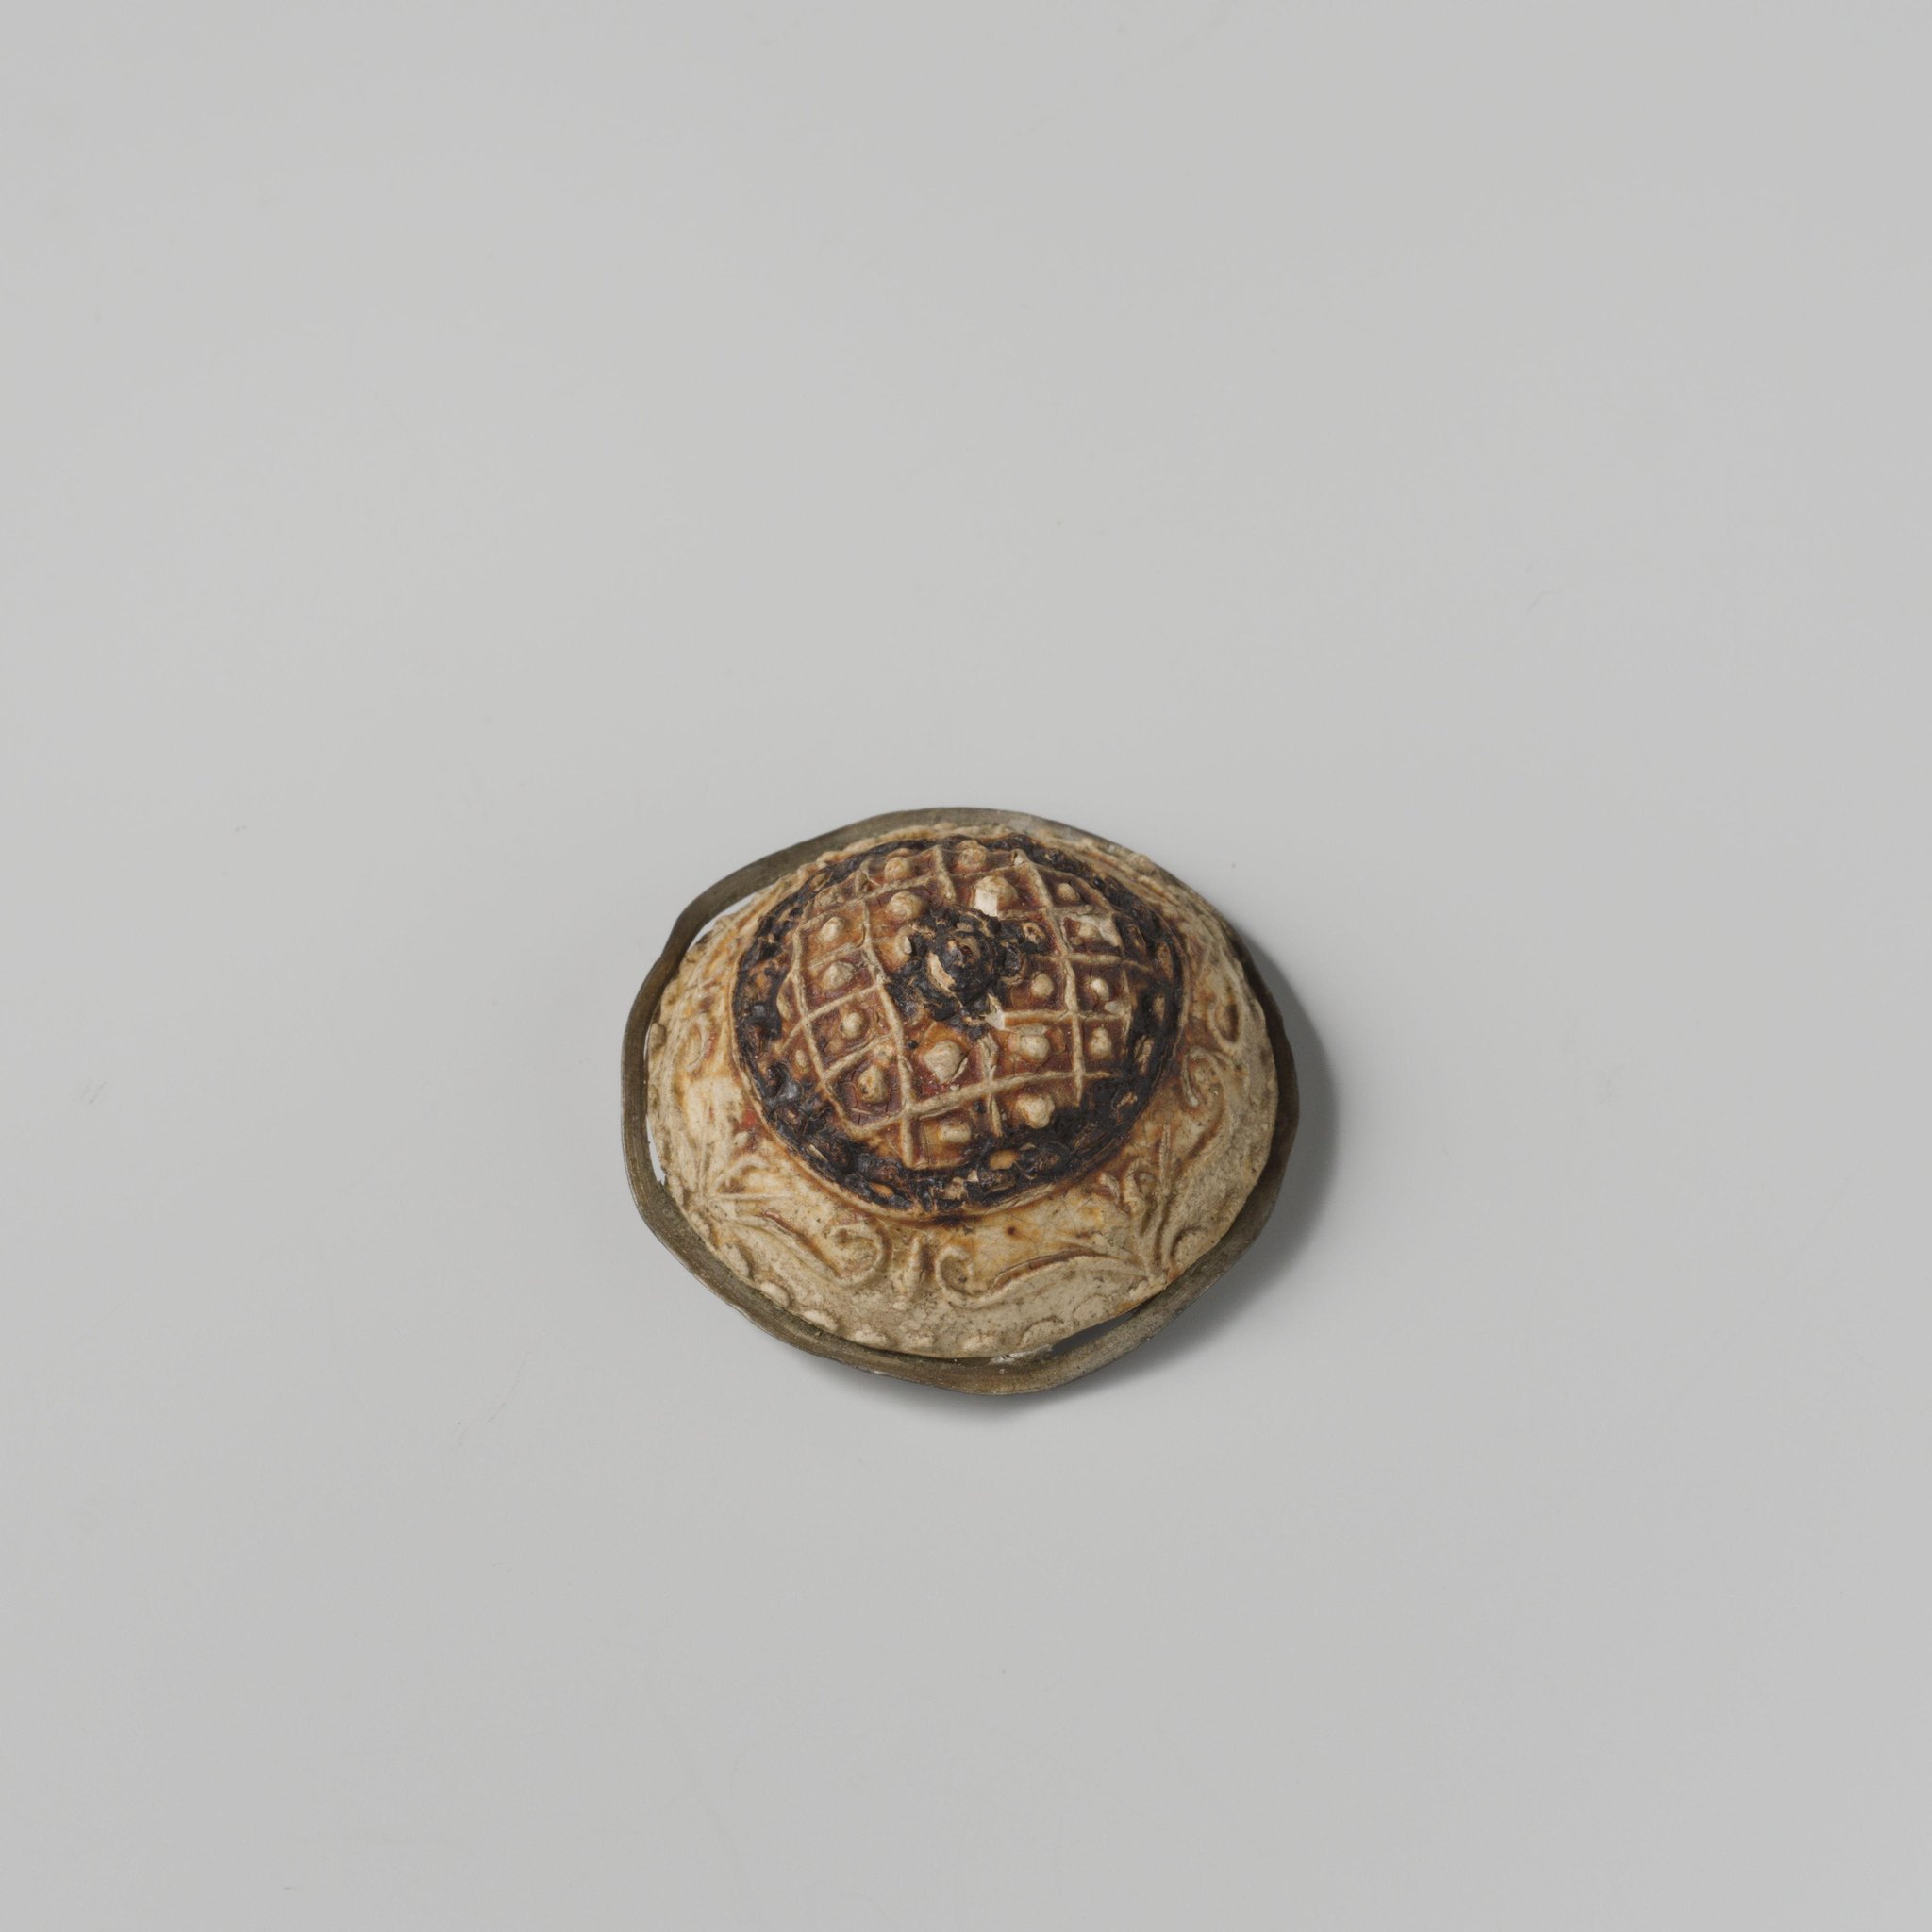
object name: pastei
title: Schotel met ronde pastei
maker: Anonymous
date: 1800-1899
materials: tin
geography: germany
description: Schotel, gedraaid van tin, waarop een ronde pastei.